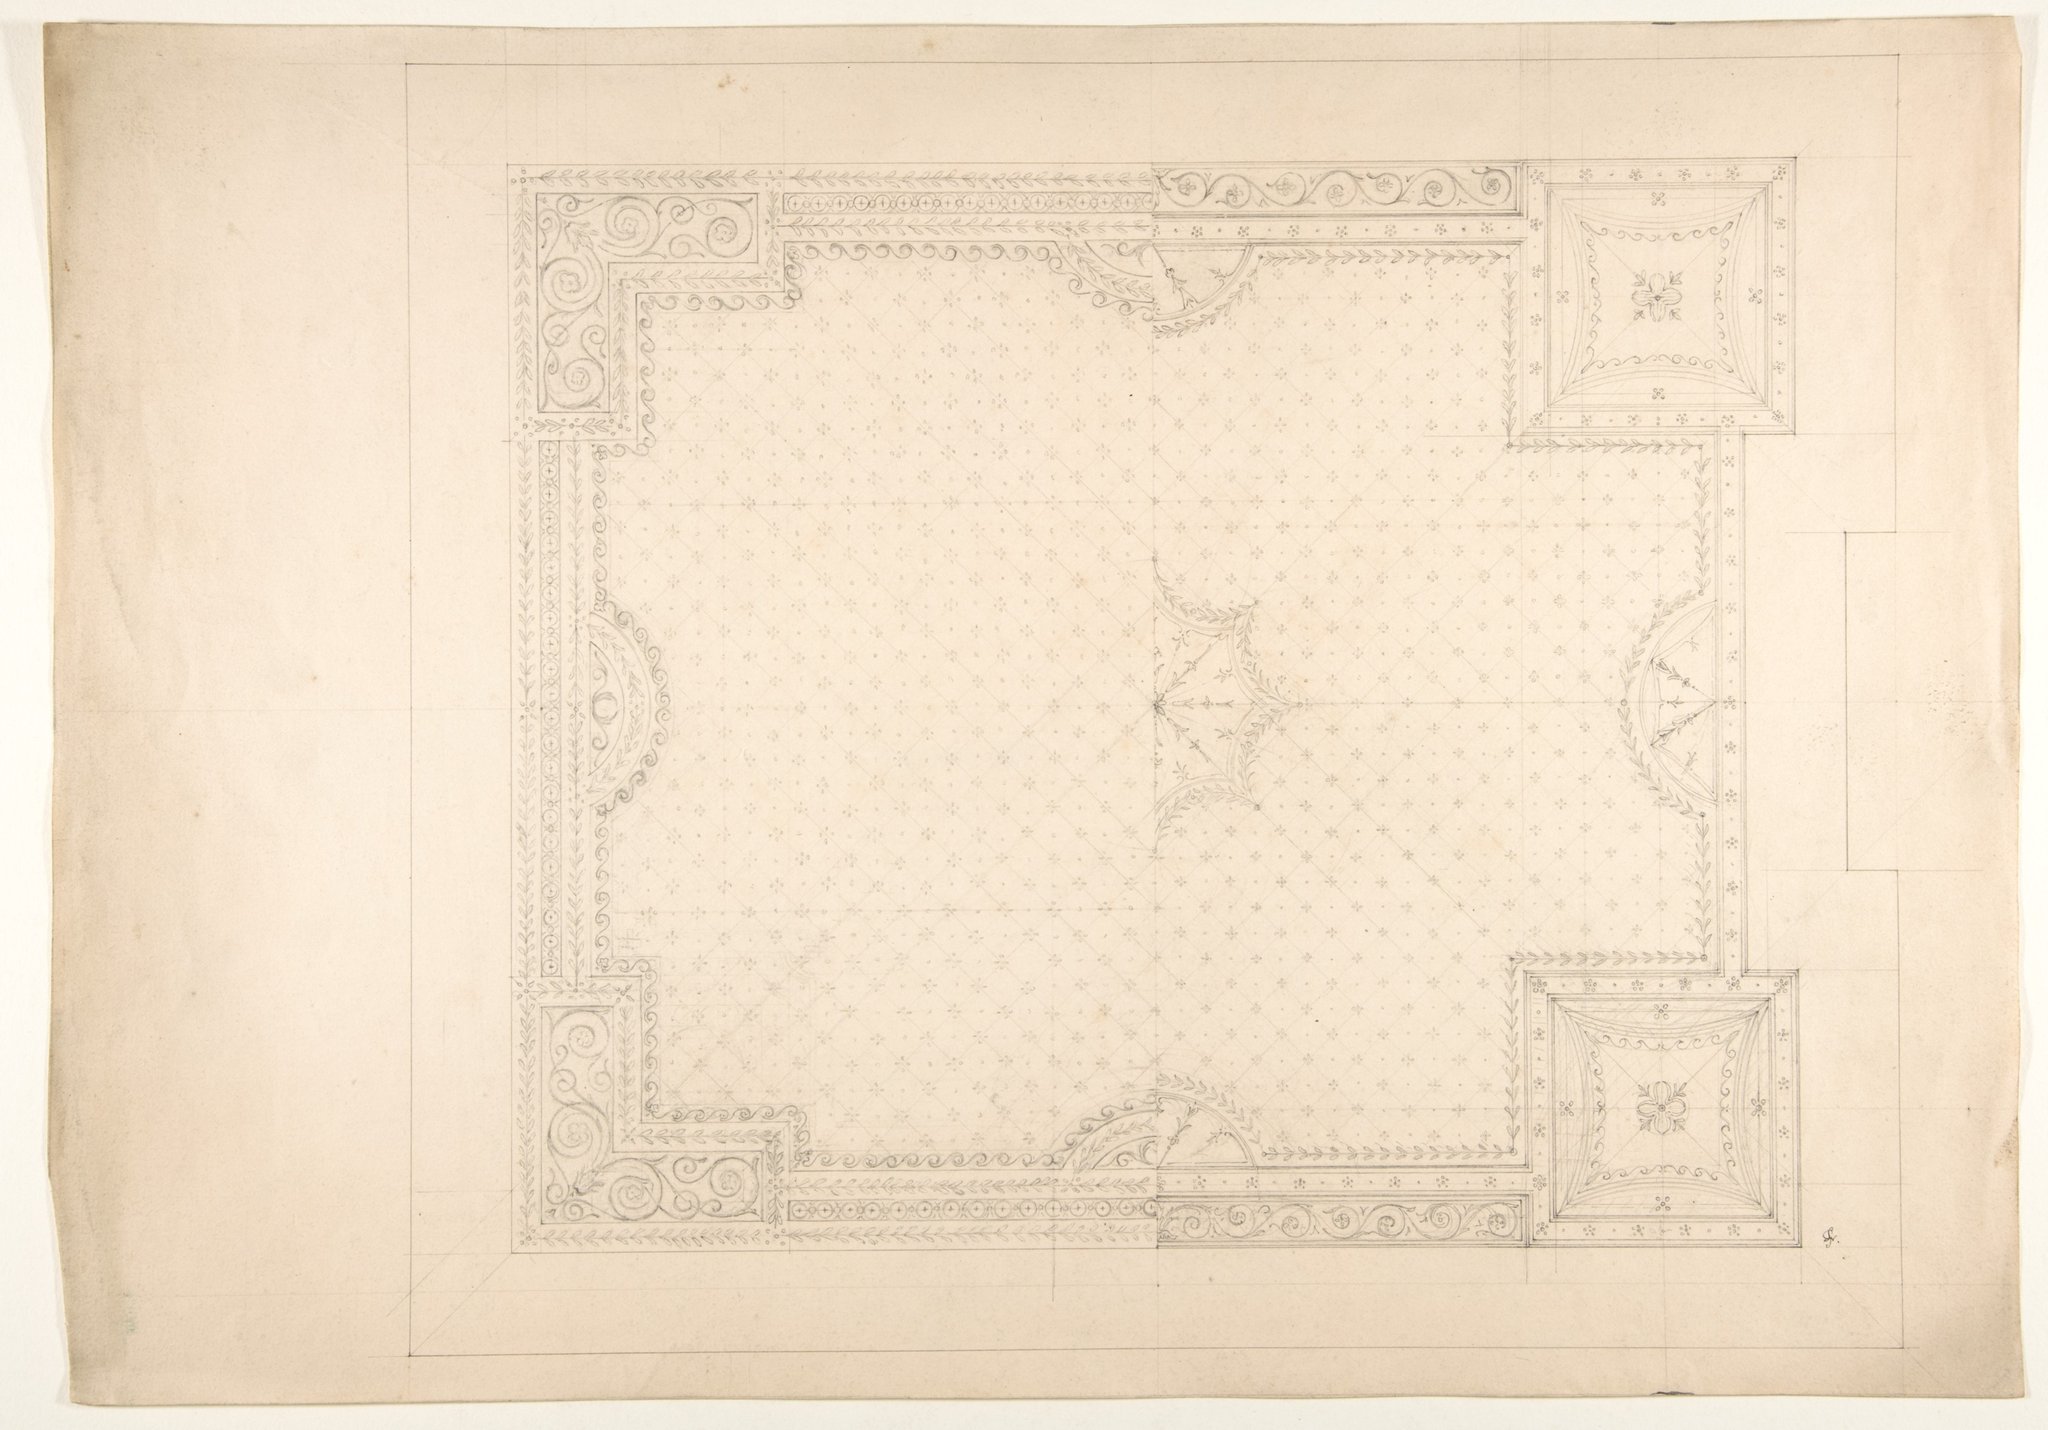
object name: drawing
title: Design for a ceiling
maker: jules-edmond-charles lachaise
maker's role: artist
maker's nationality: french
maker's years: 1897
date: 1851-1900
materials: graphite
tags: ceilings